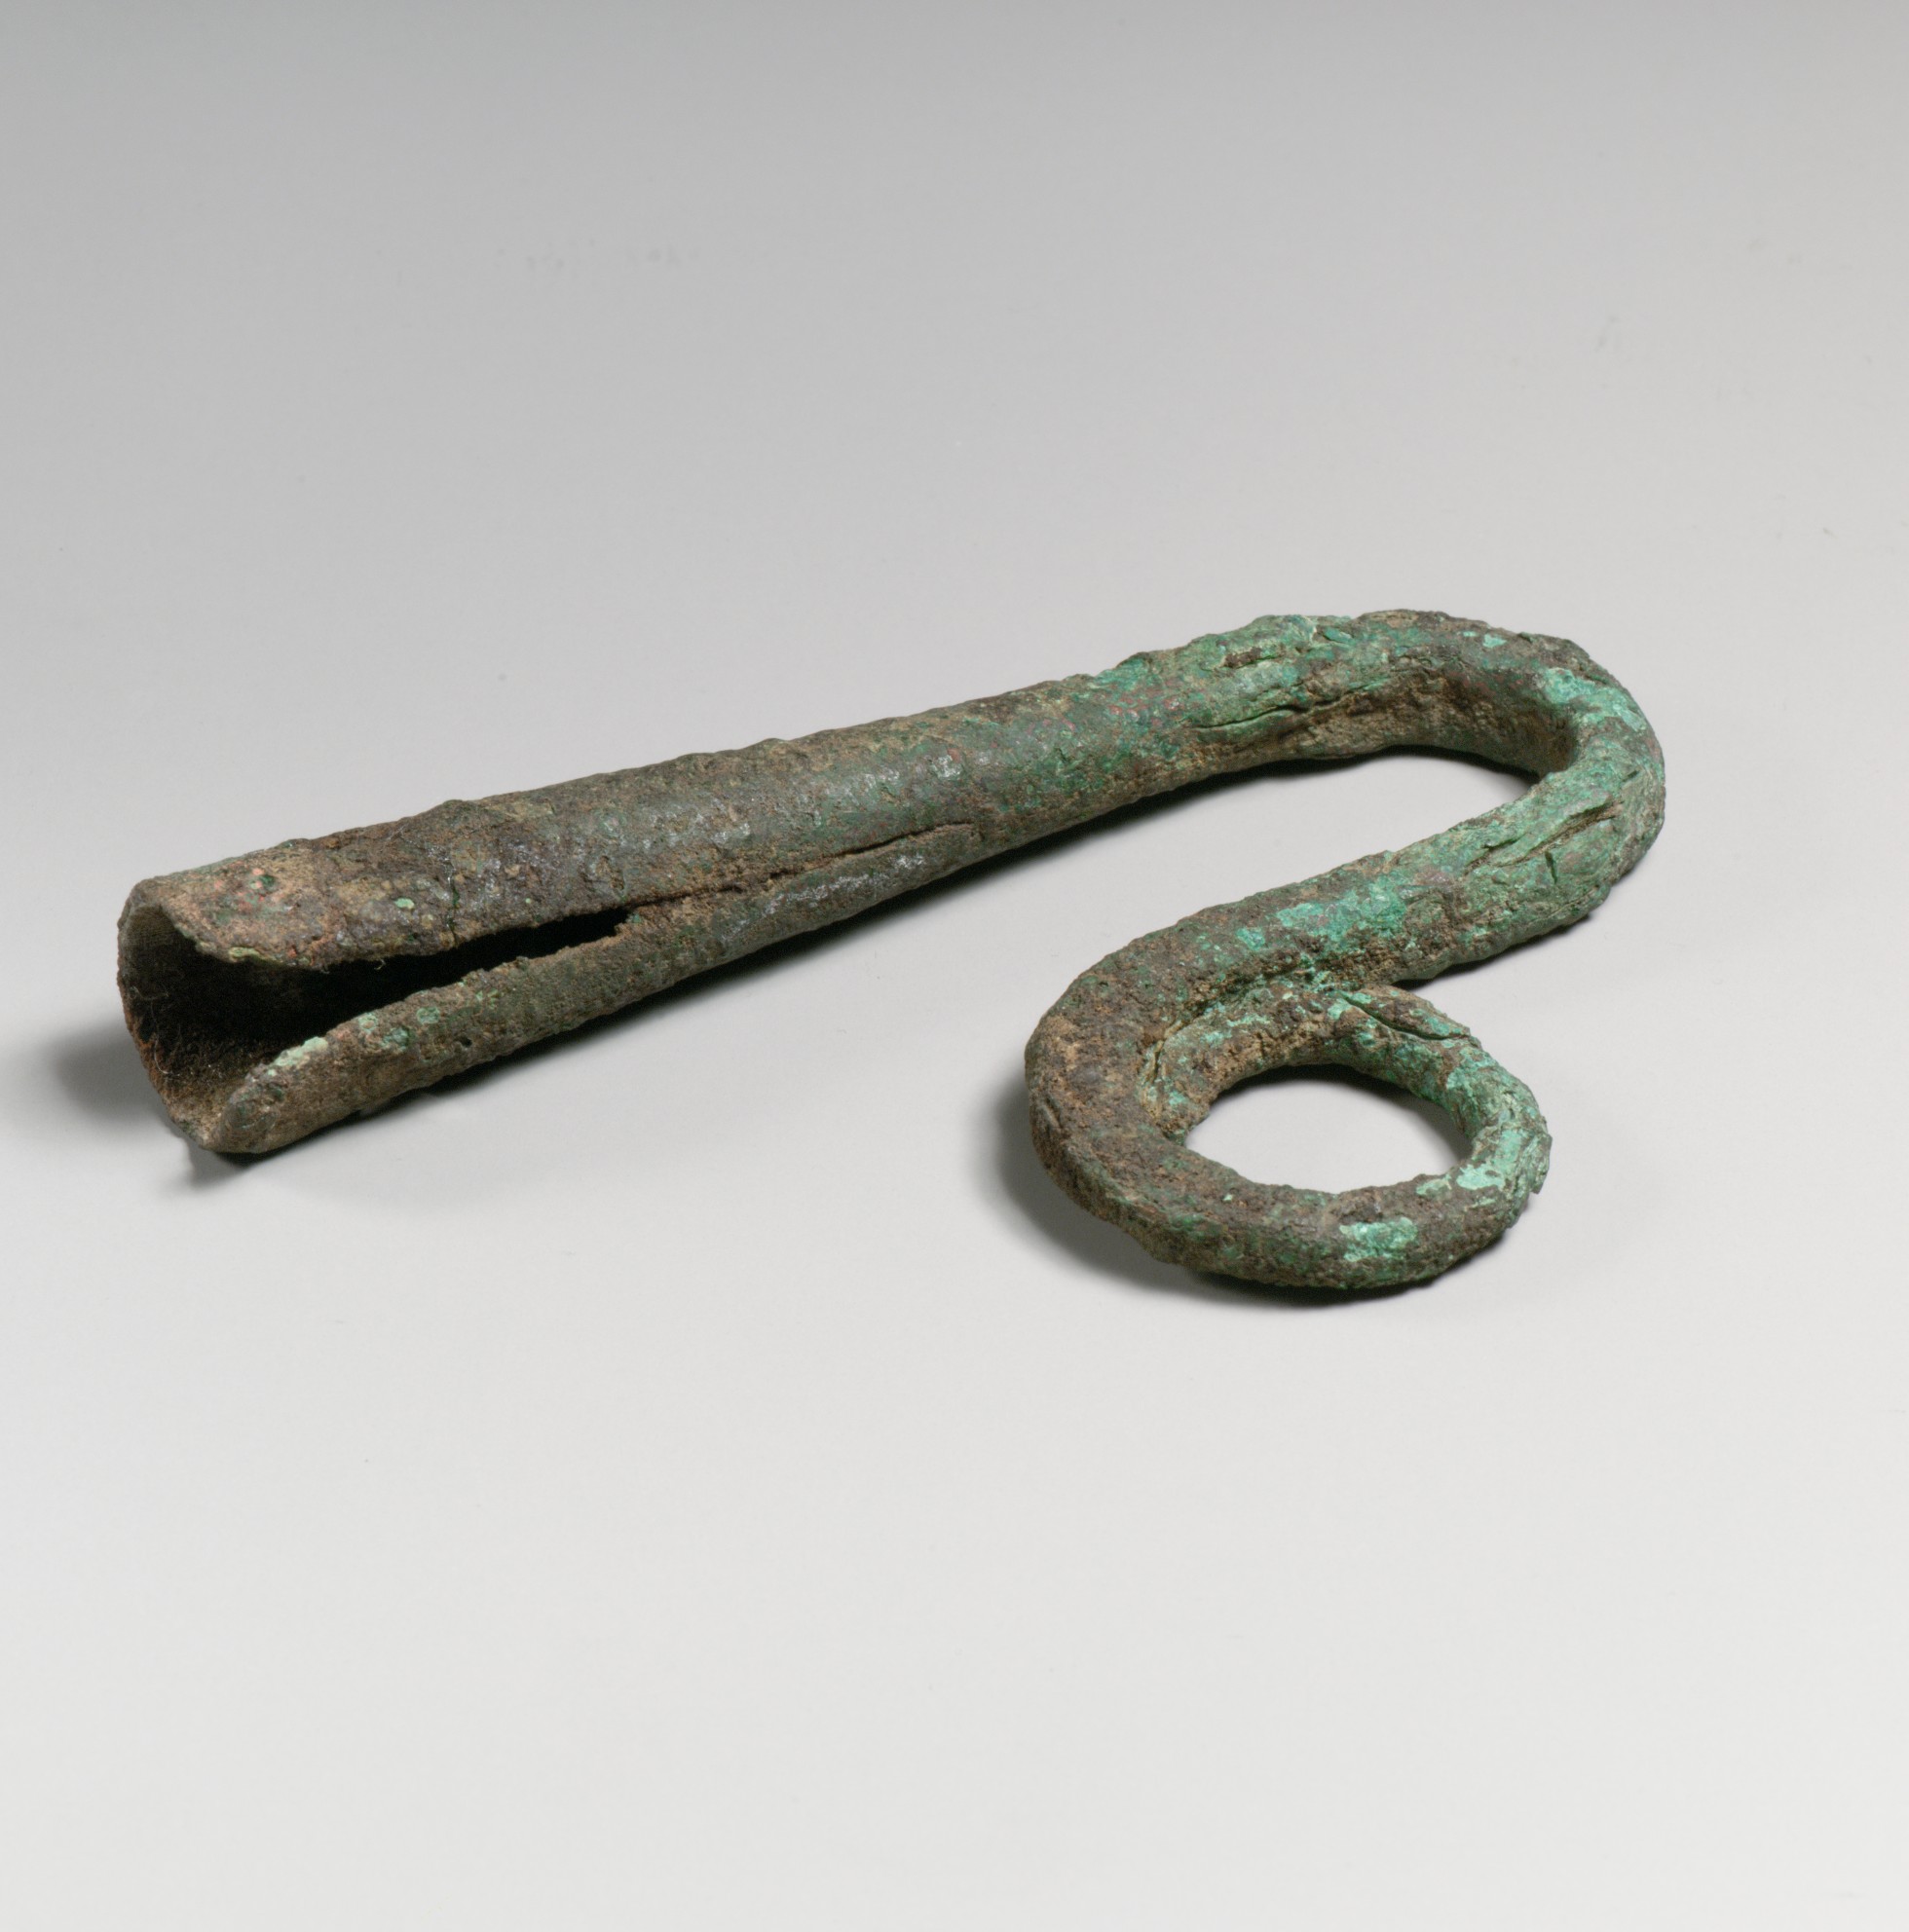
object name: shepherd's crook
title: Bronze shepherd's crook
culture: cypriot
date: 1200-1050 BCE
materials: bronze